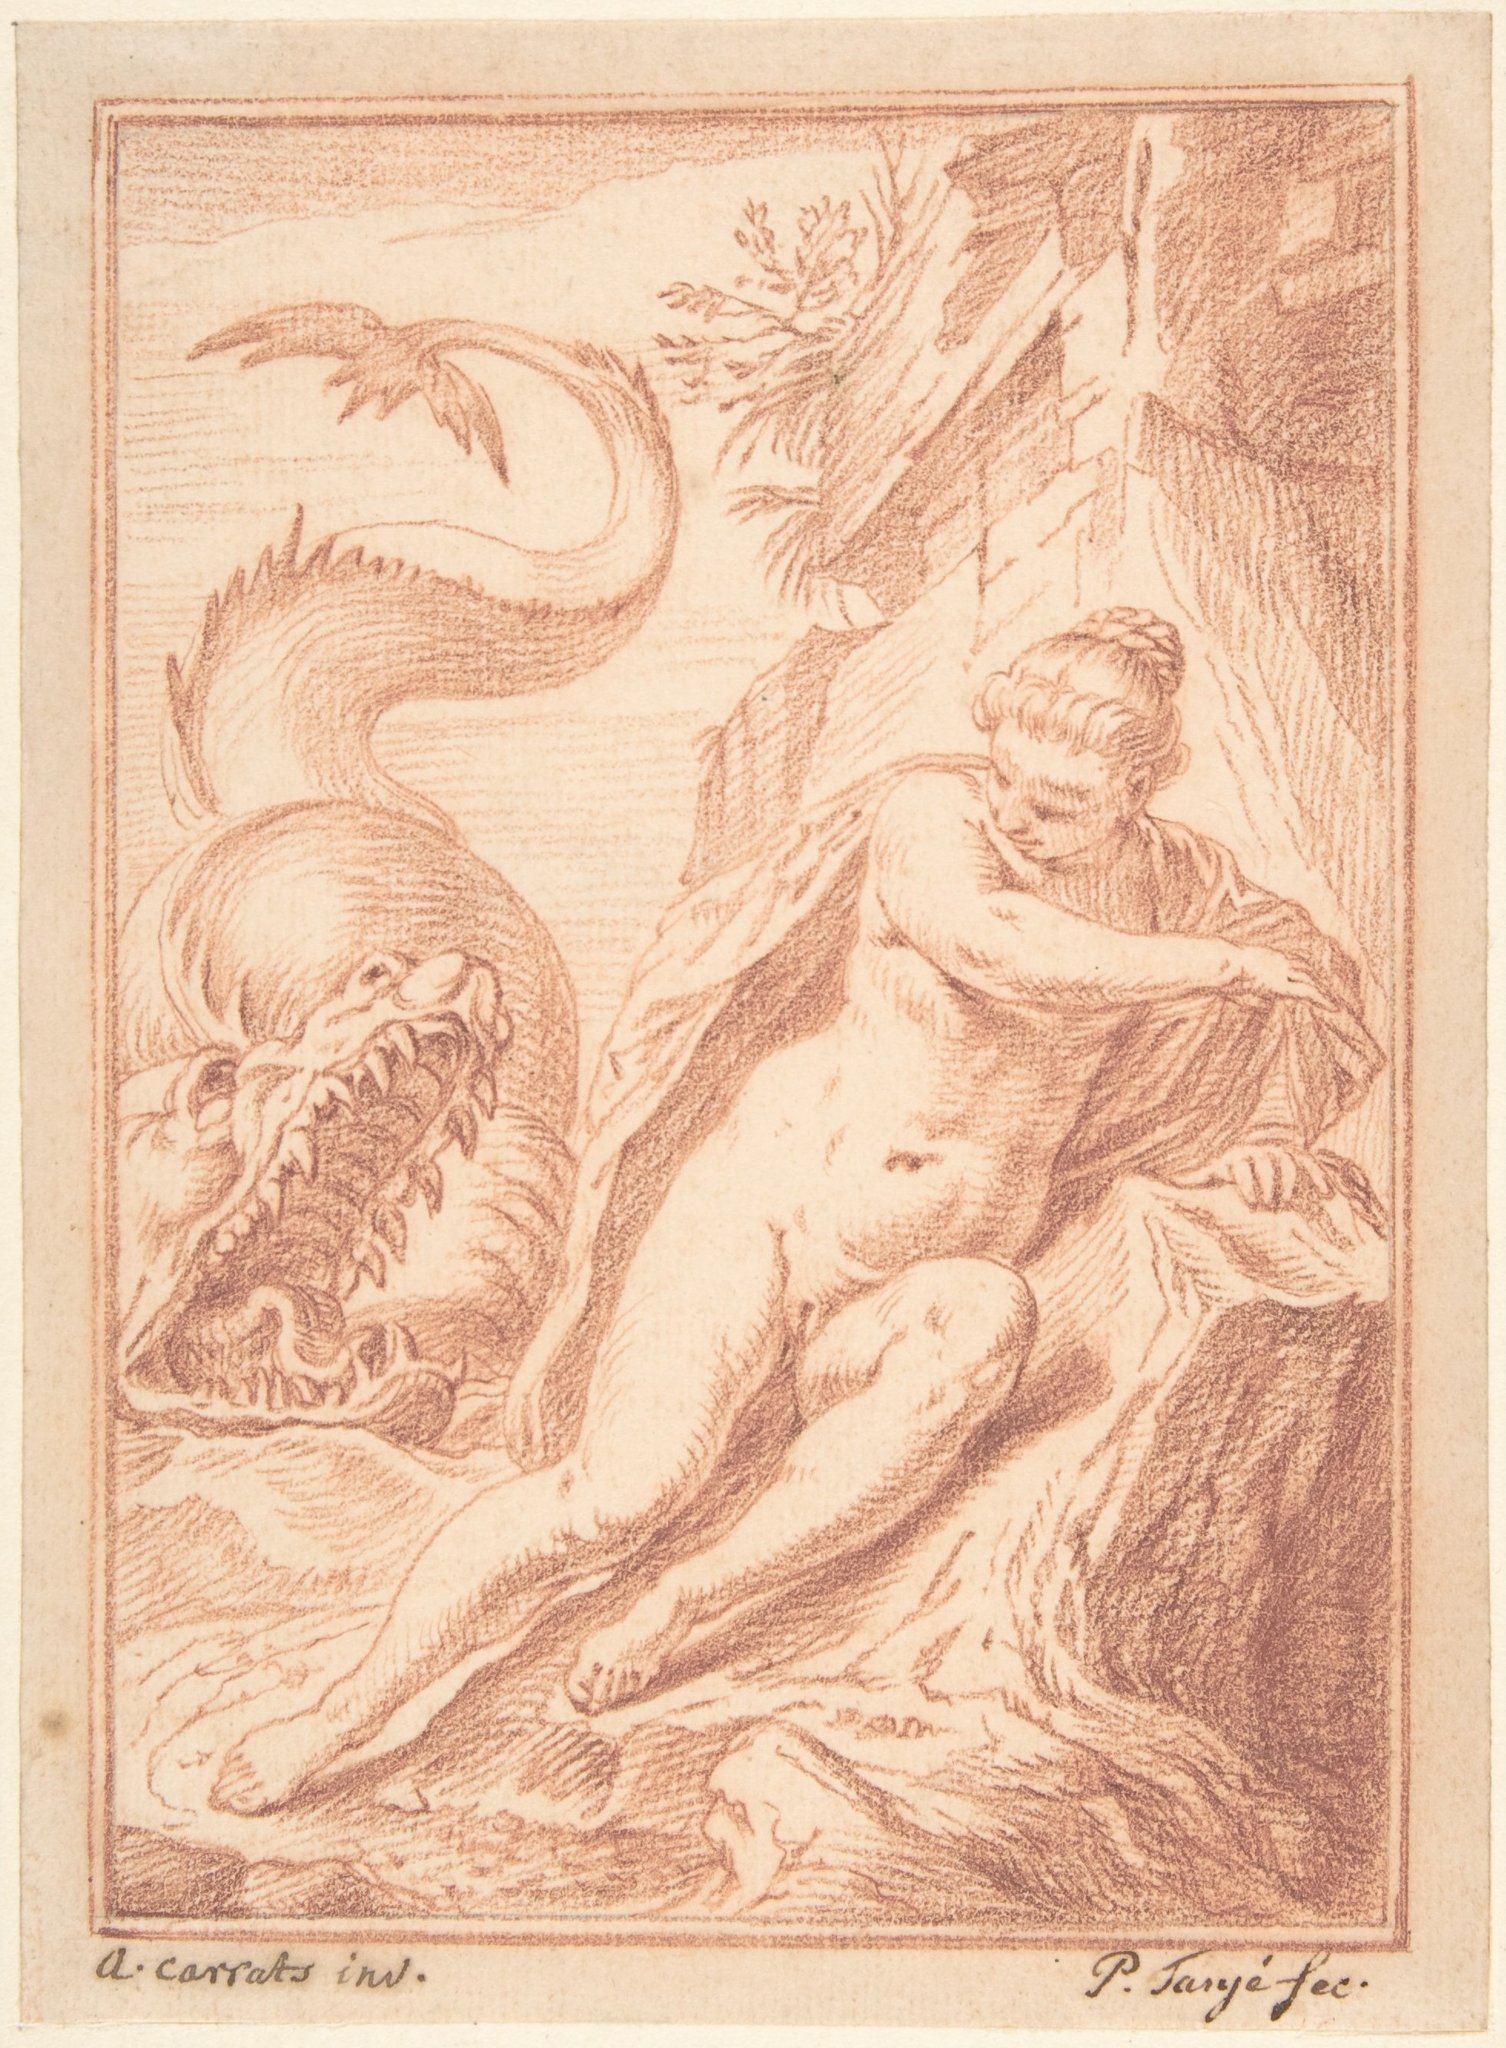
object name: drawing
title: Andromeda, after Agostino Carracci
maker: pieter tanjé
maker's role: artist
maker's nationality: dutch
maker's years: 1706-1761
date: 1701-1800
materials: chalk, gold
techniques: inlay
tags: animals,andromeda